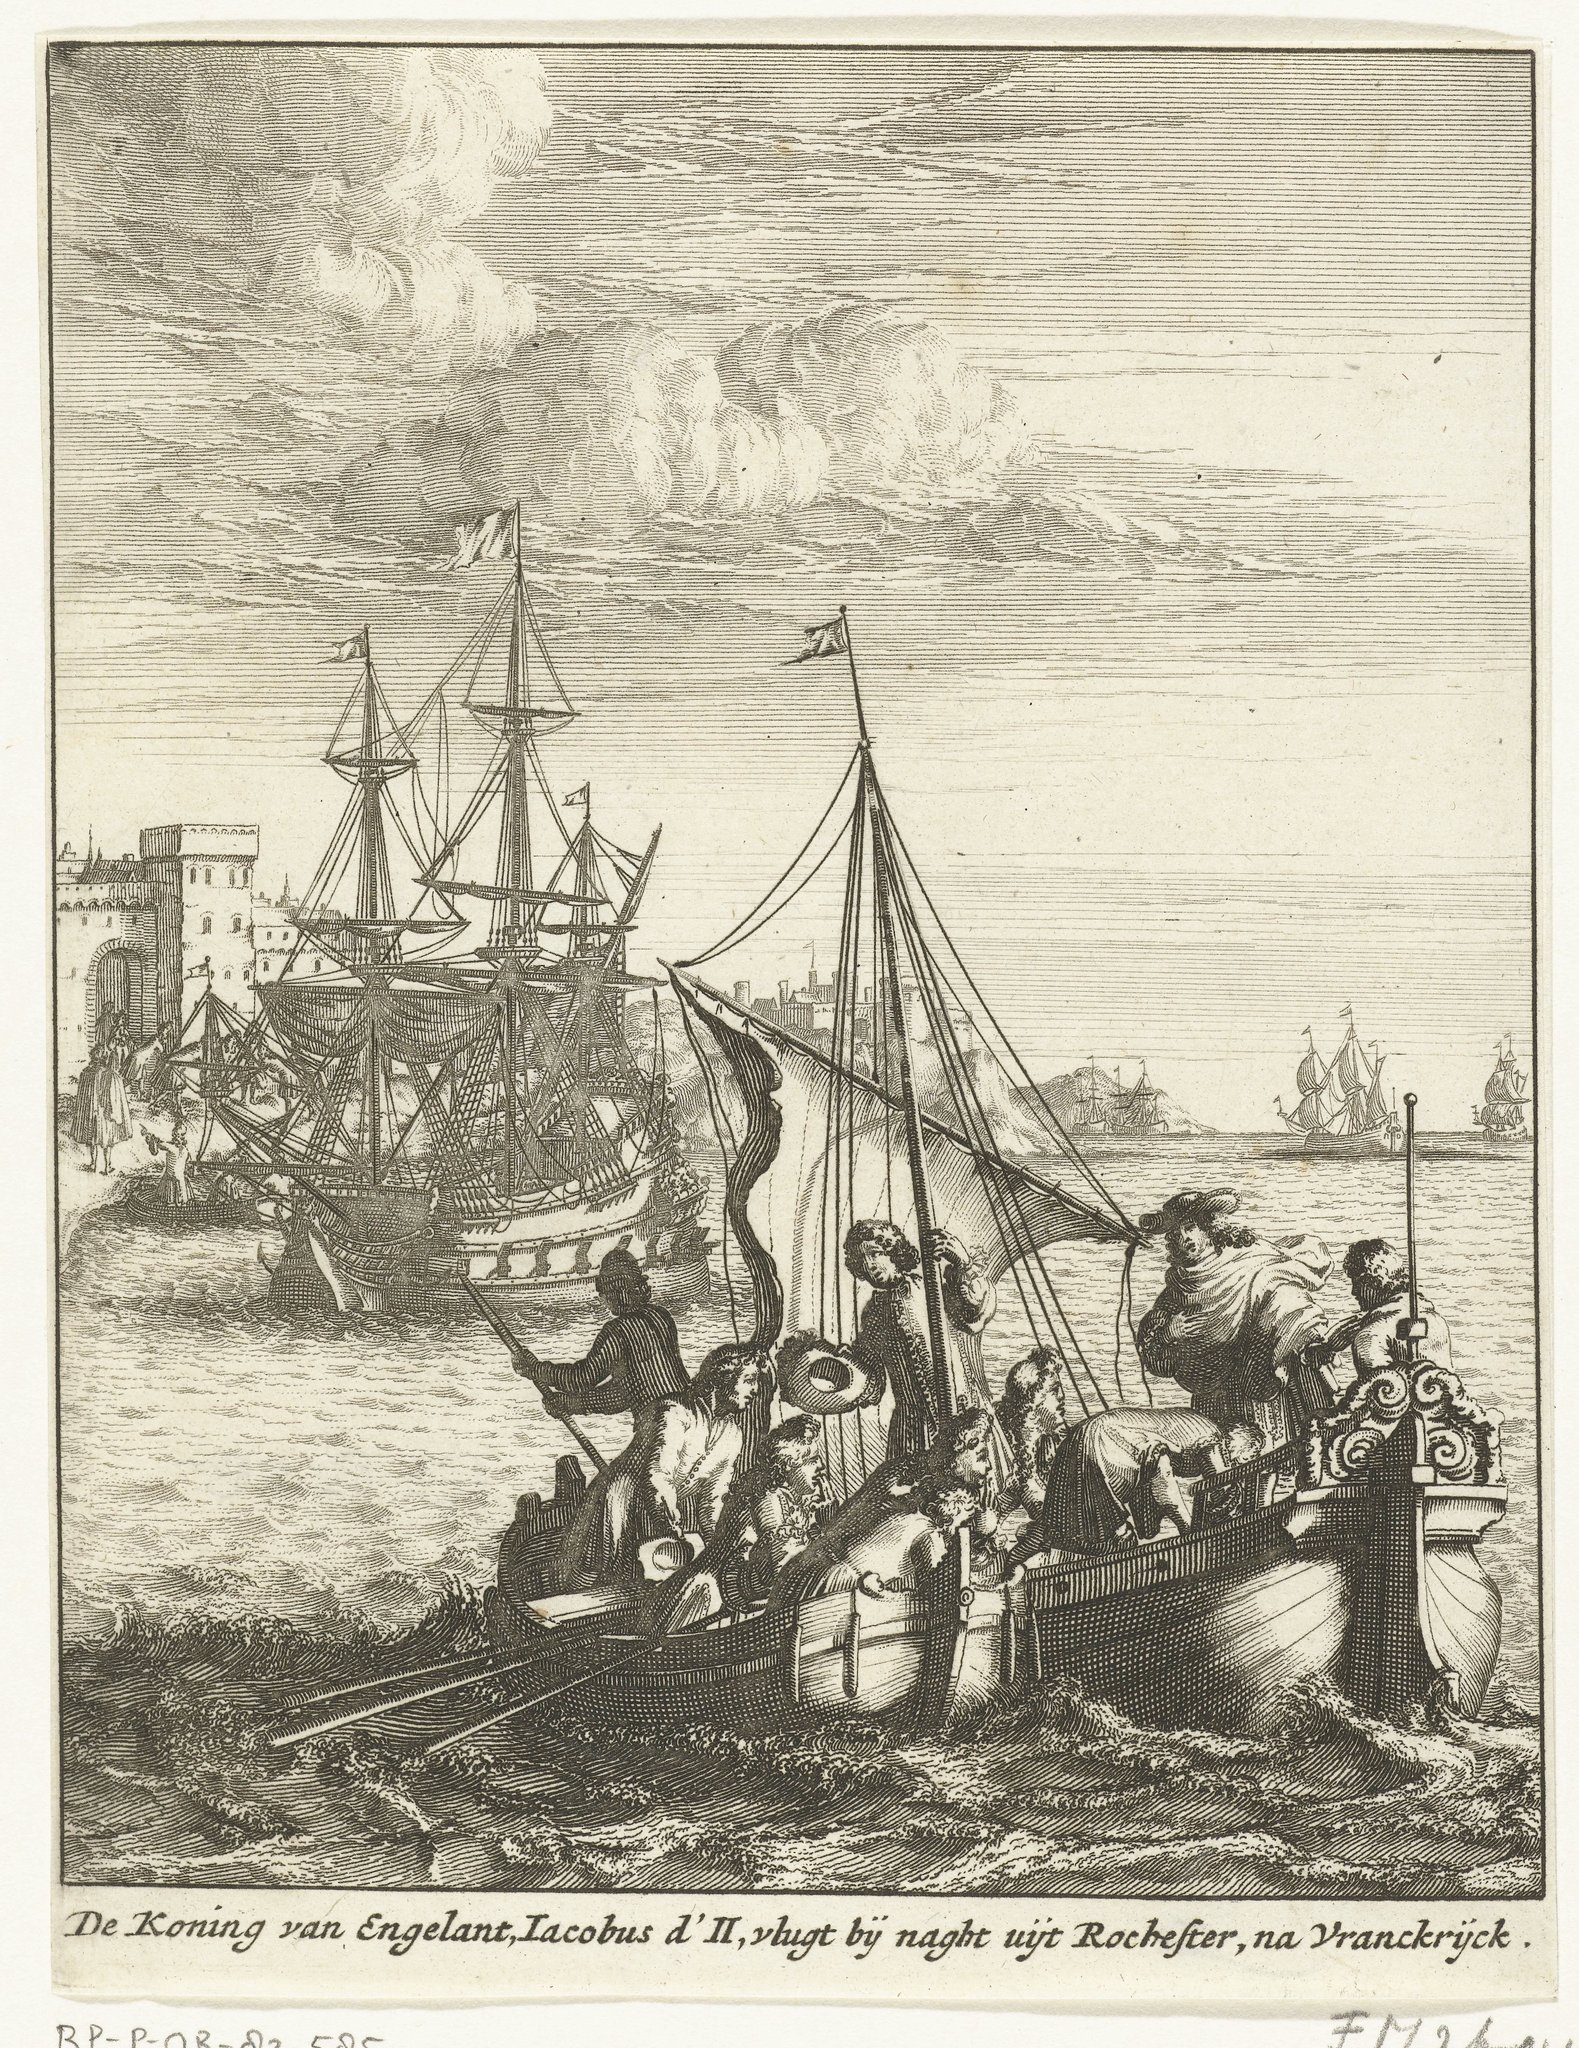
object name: print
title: De Koning van Engelant, Jacobus d'II, vlugt bij naght uijt Rochester, na Vranckrijck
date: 1689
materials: paper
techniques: etching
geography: northern netherlands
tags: jacobus ii (koning van engeland en schotland), flight of ruler from adversary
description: Gebruikt als illustratie in: Abraham van Poot, Engelands gods-dienst en vryheid hersteld, door s?n hoogheid den heere prince van Oranjen, Marcus Willemsz Doornick, Amsterdam, 1689.